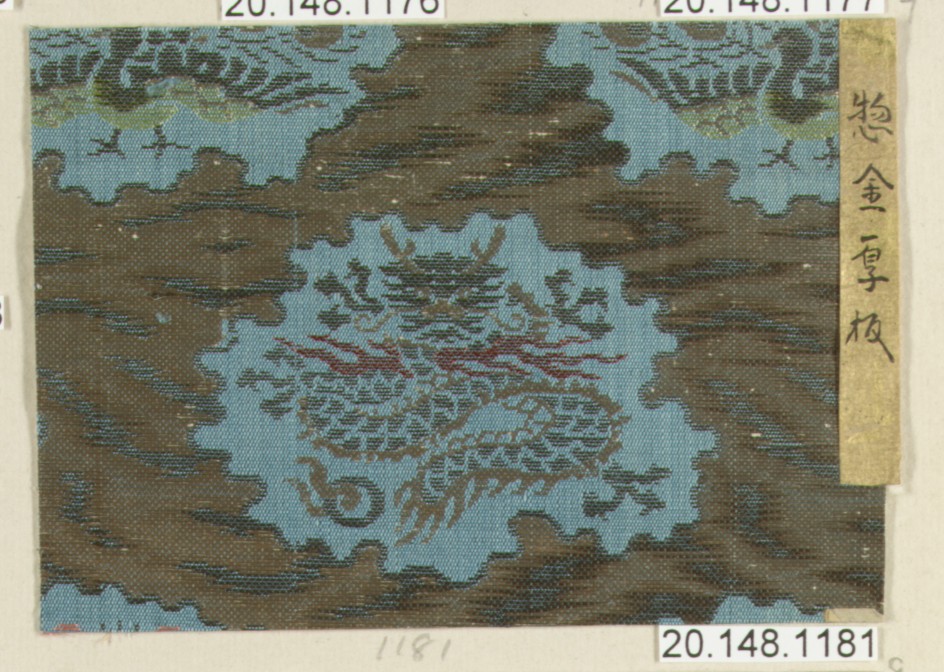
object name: piece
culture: japanese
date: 1601-1700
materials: silk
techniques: compound weave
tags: birds,dragons